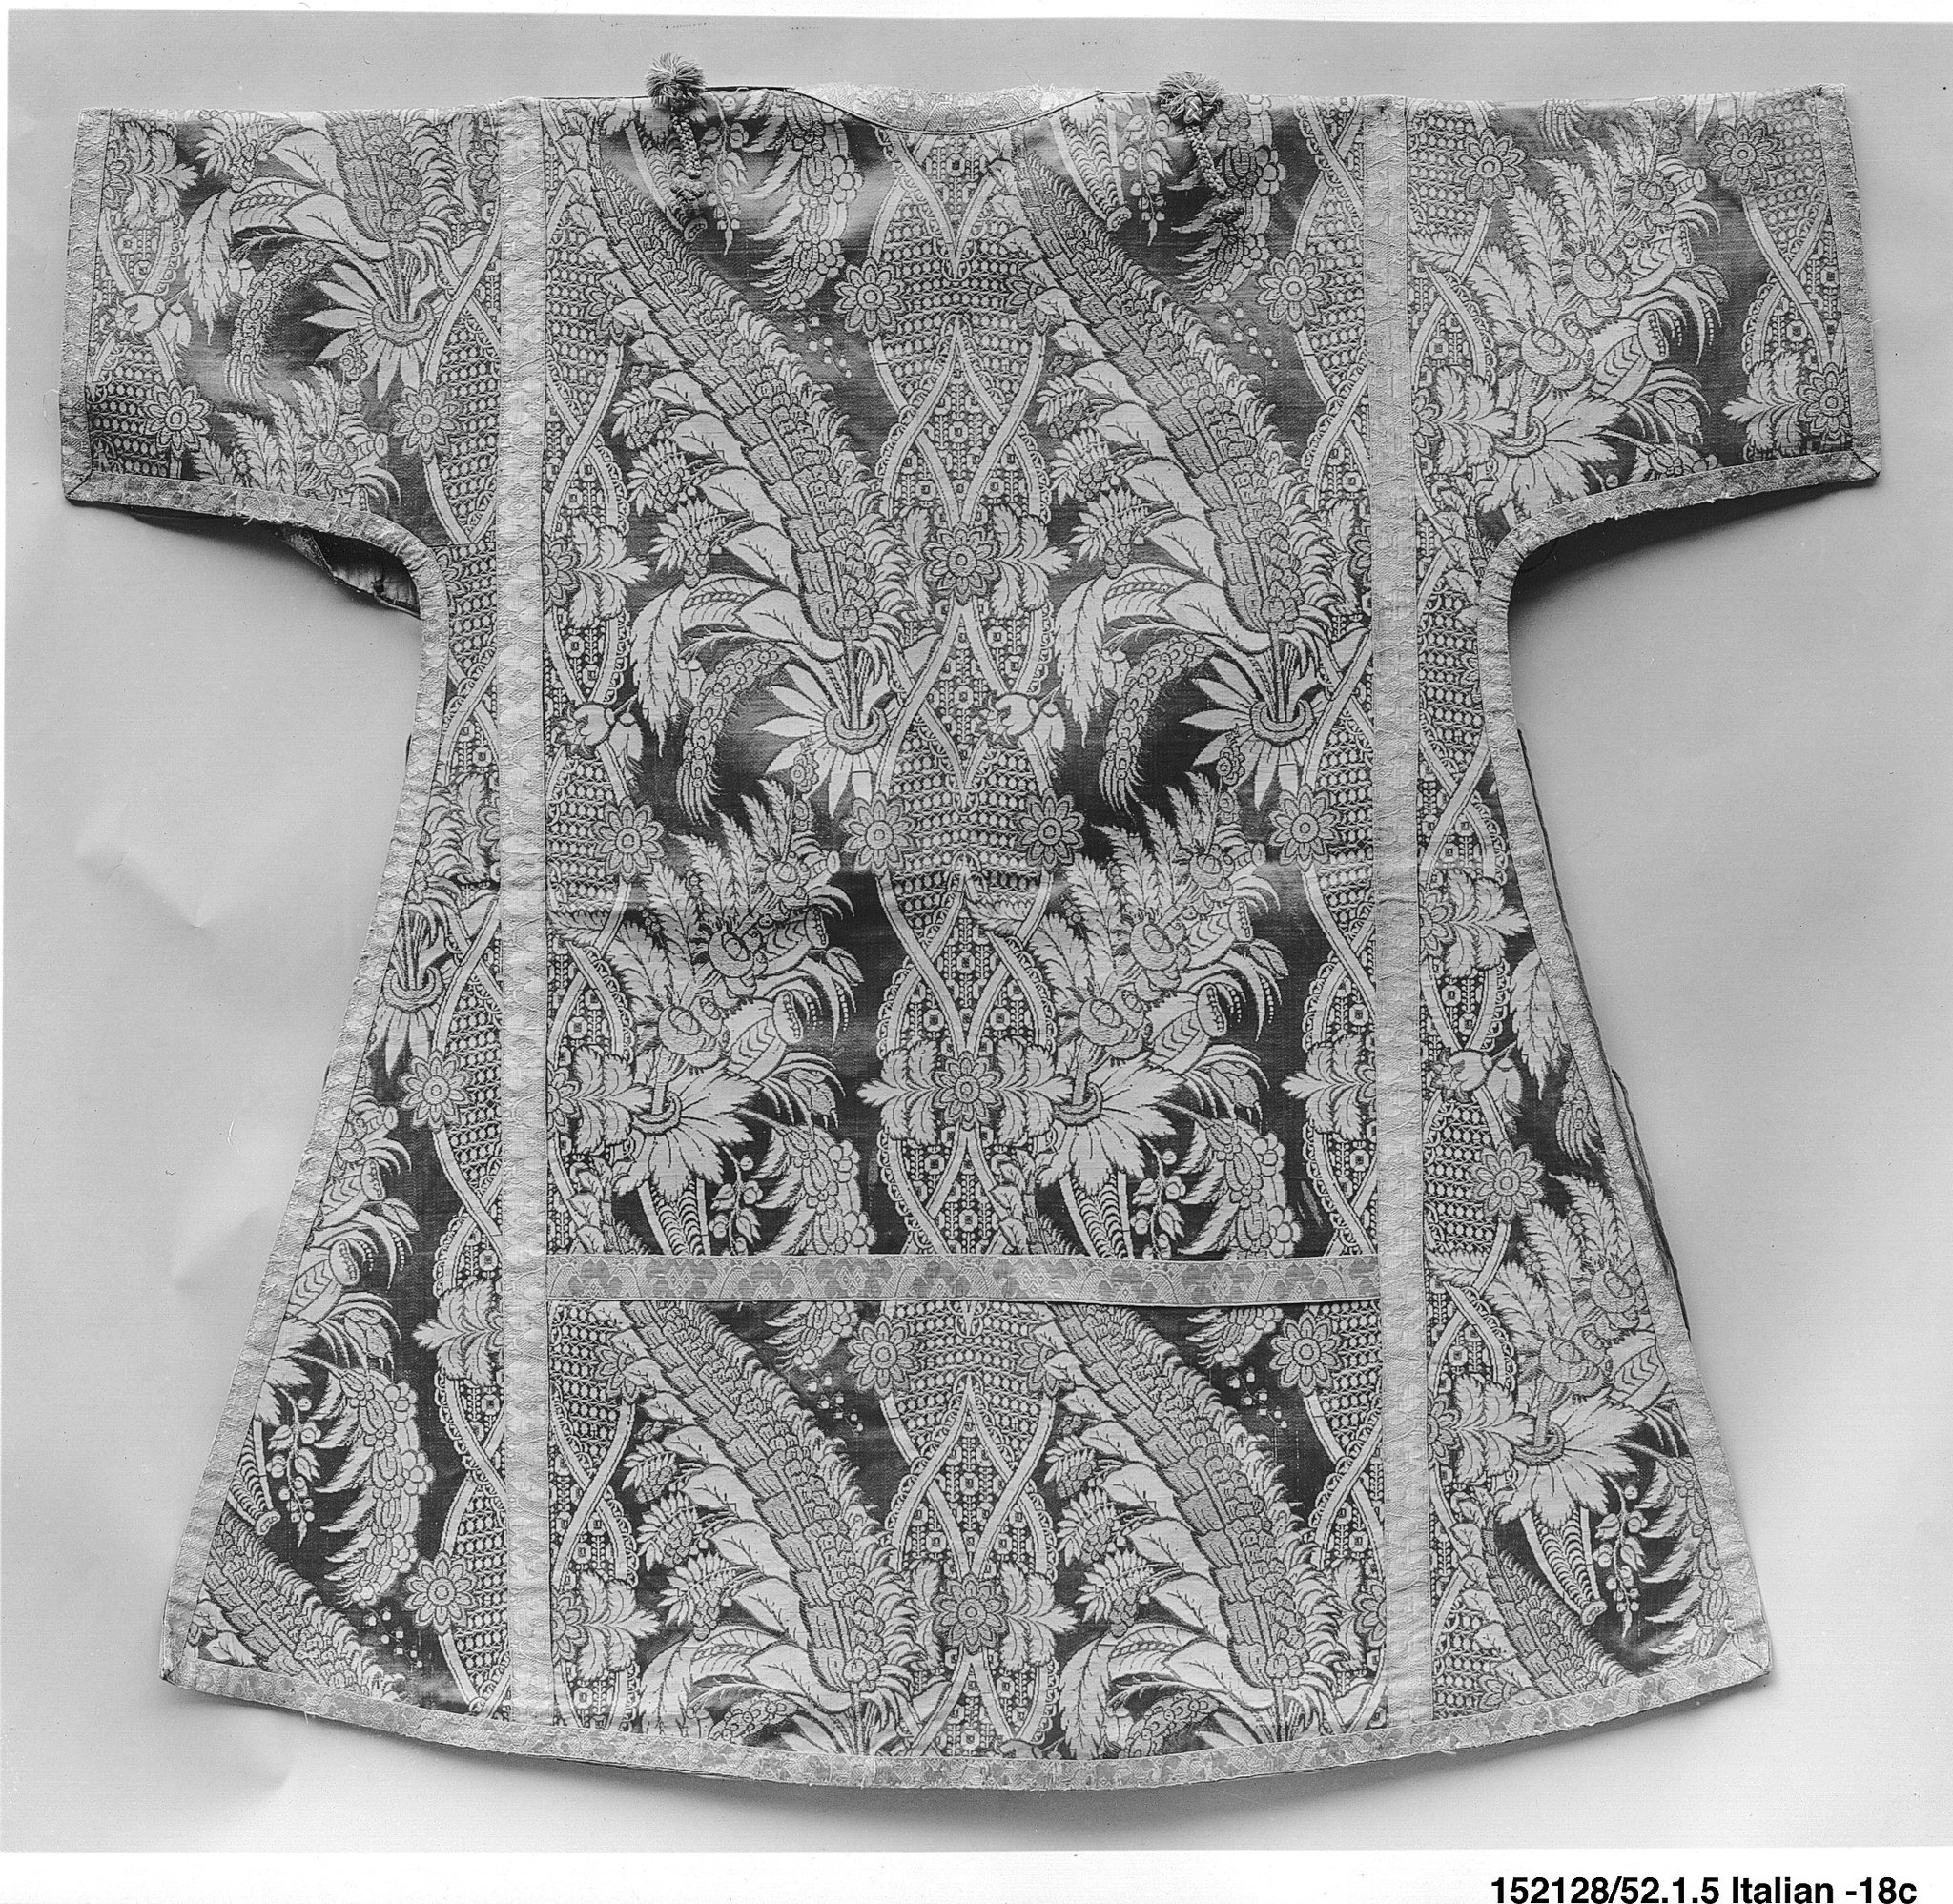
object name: dalmatic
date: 1720-1725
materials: metal thread, silk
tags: flowers,leaves